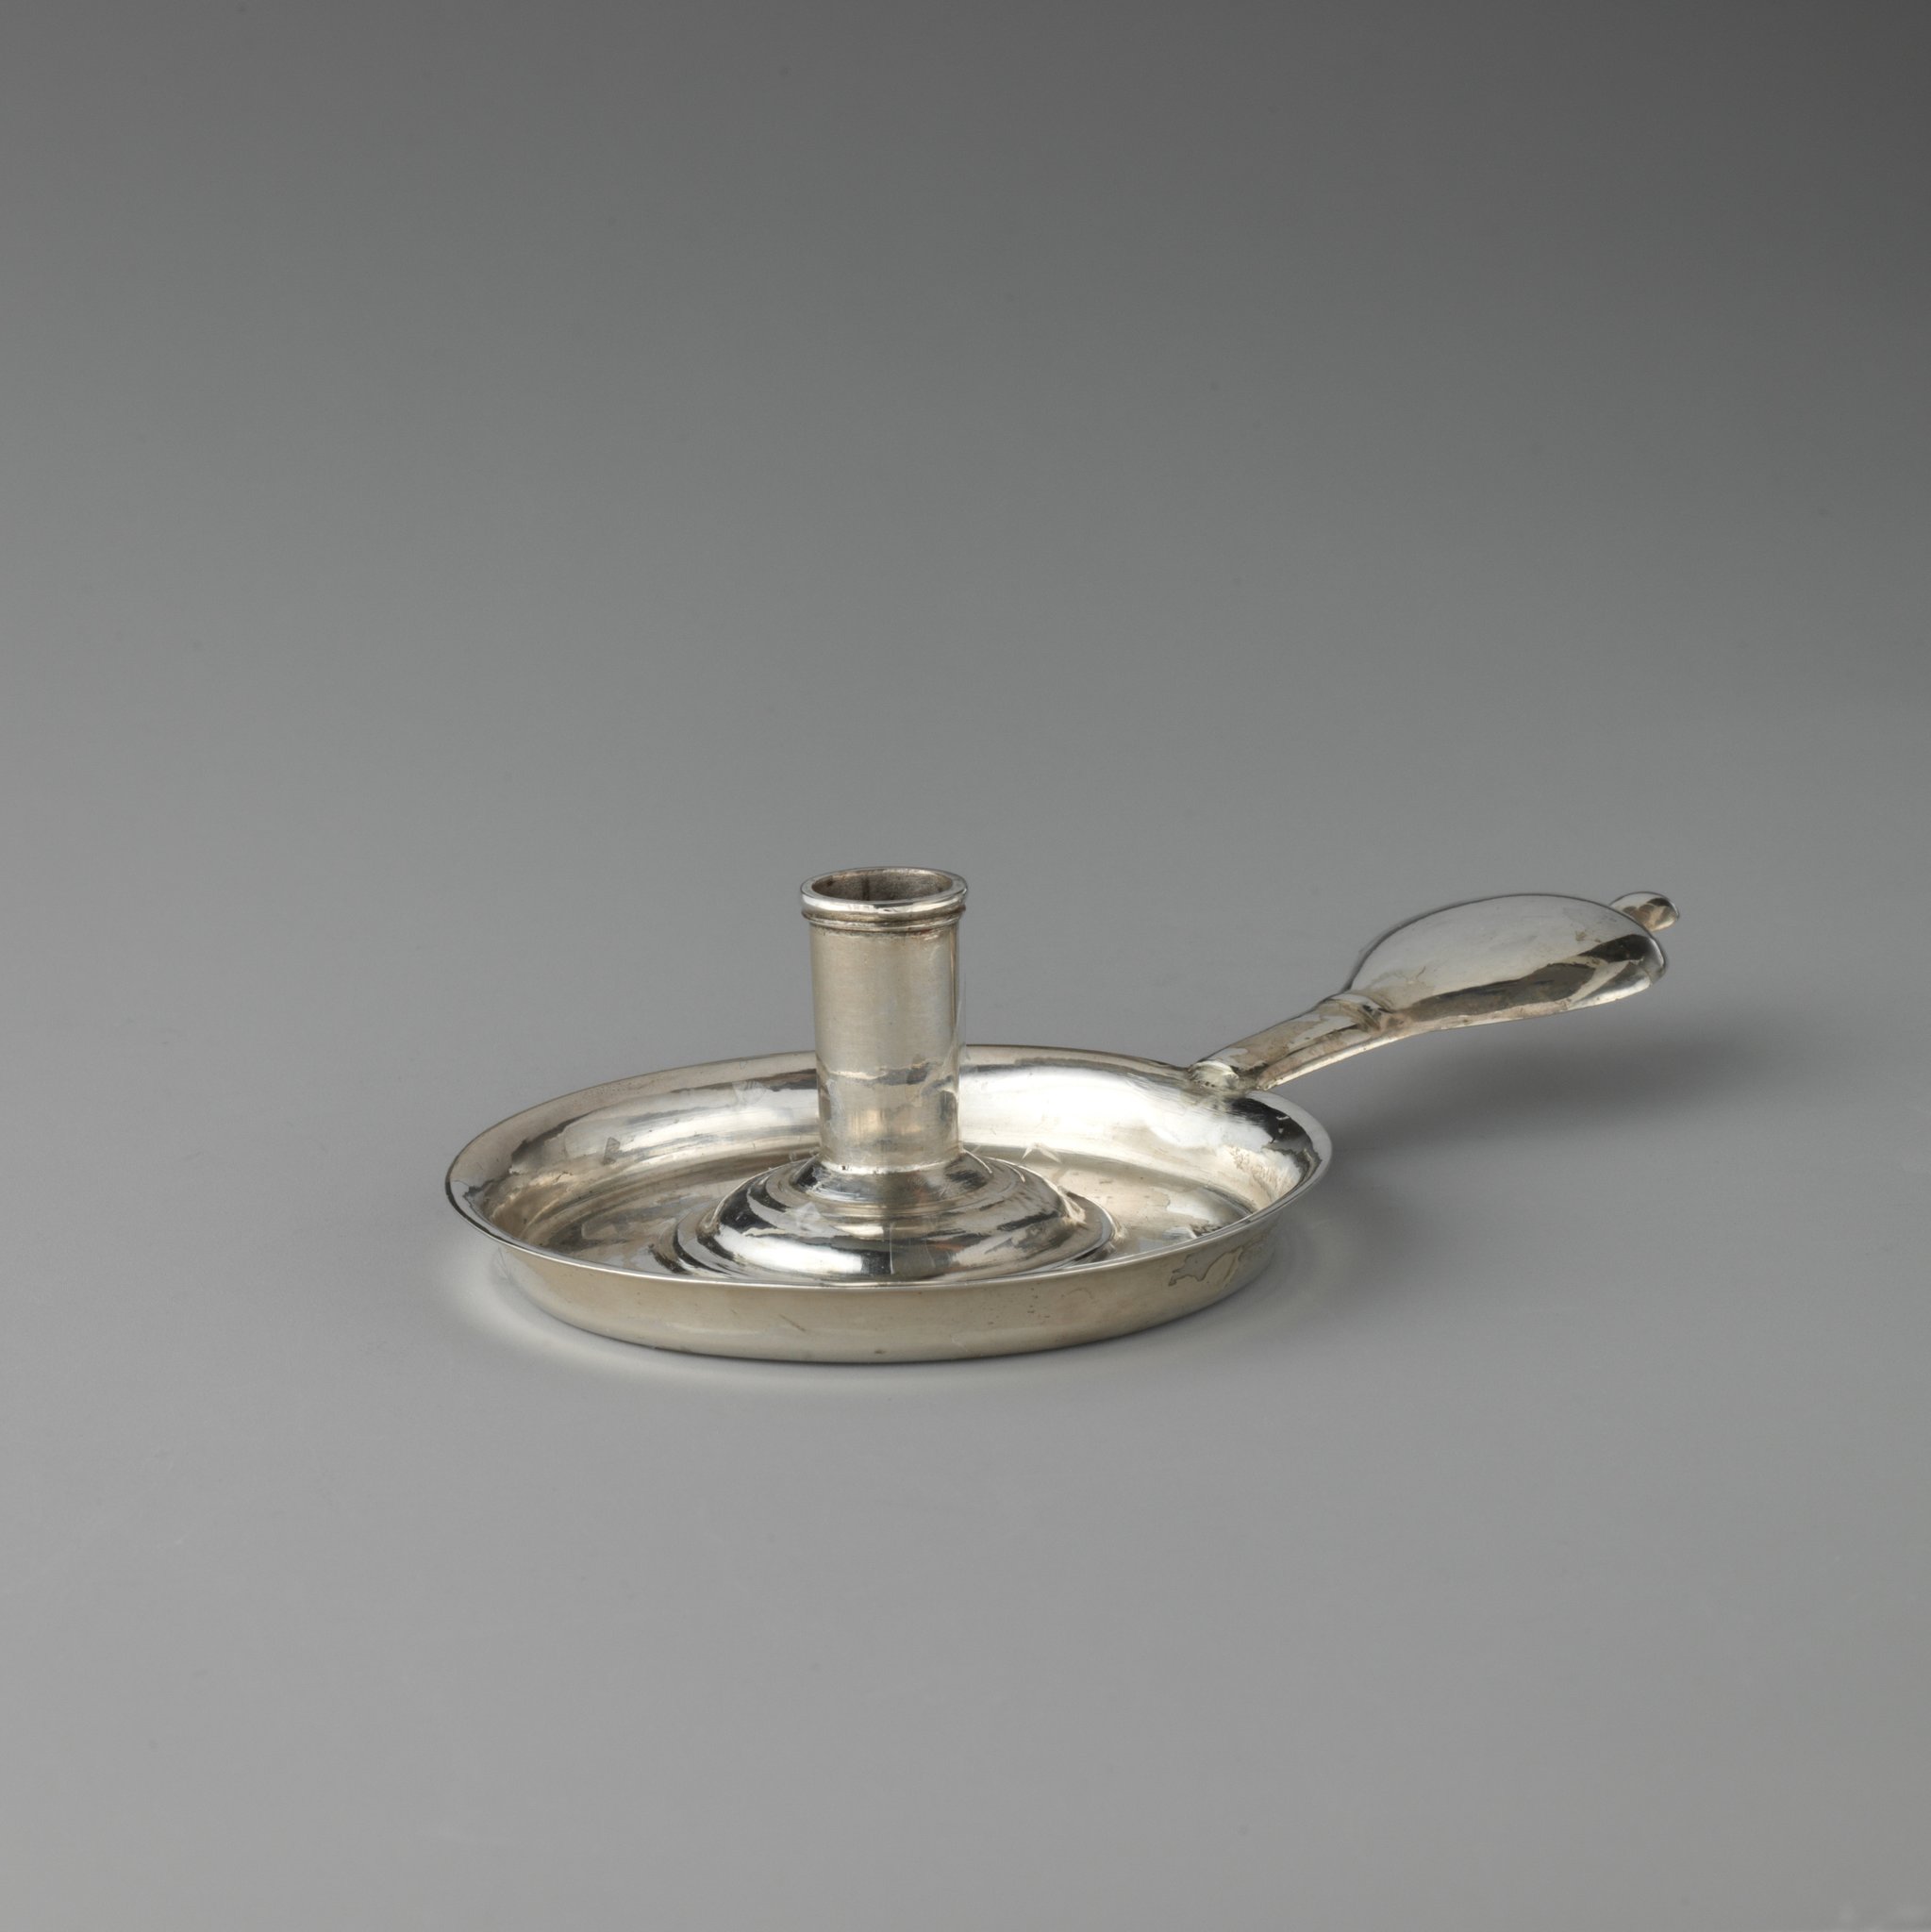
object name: chamberstick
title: Miniature chamberstick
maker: david clayton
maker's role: maker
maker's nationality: british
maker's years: 1659-1719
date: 1701-1800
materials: silver